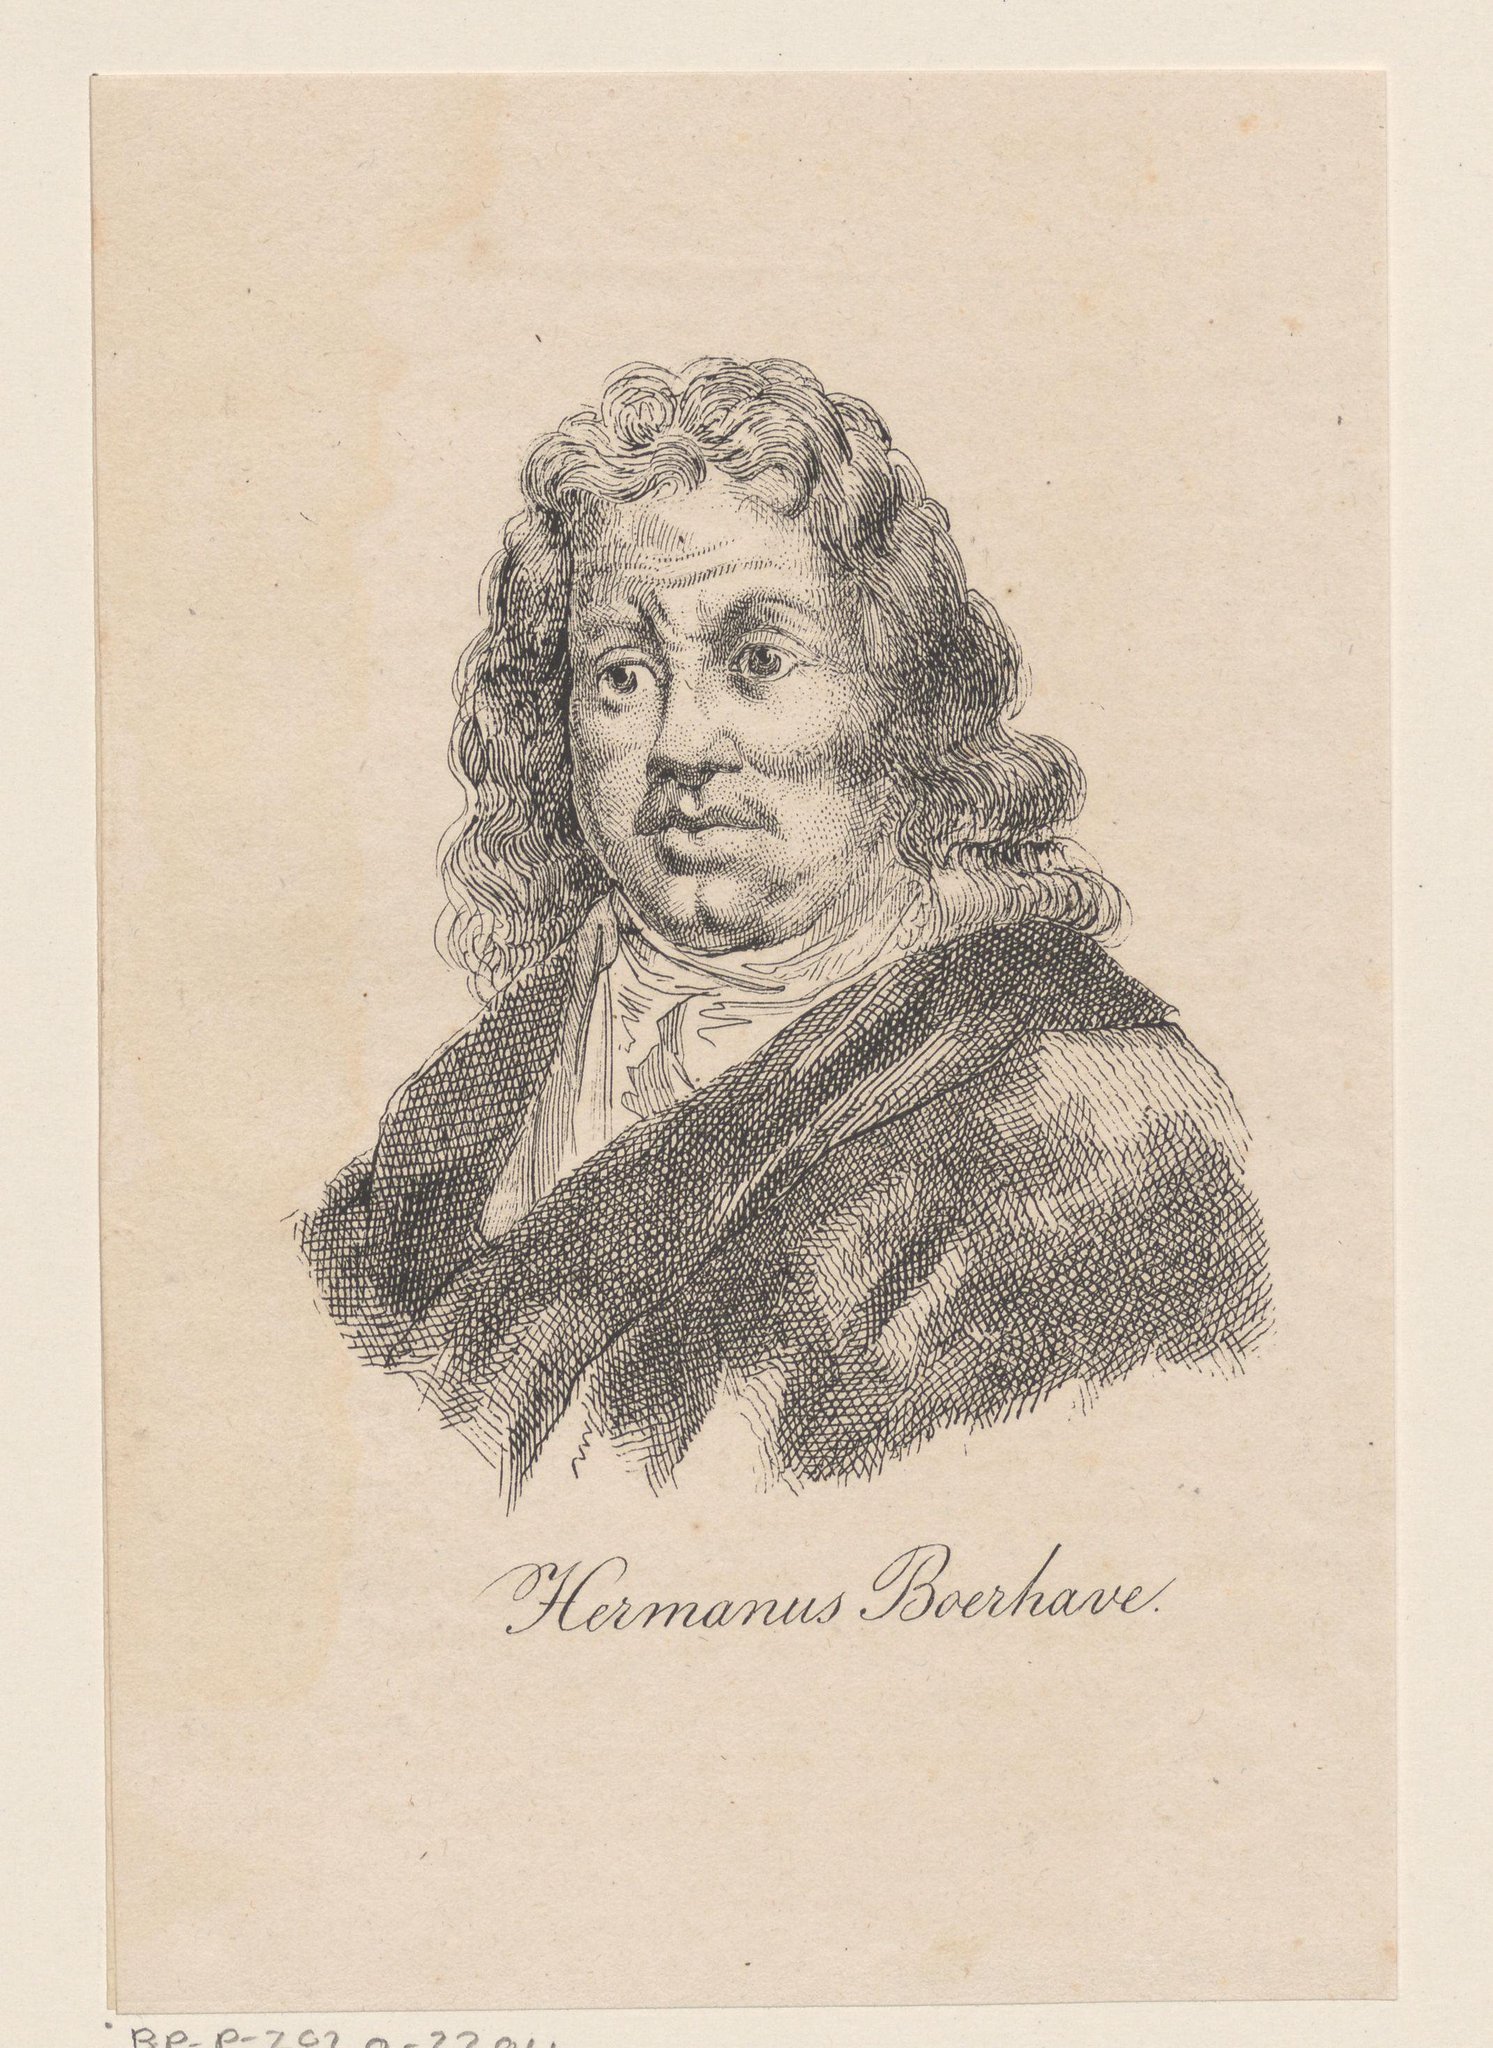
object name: print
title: Portret van Hermanus Boerhaave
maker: Anonymous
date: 1820-1850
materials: paper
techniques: lithograph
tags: leiden, hermanus boerhaave, historical persons, physician, doctor